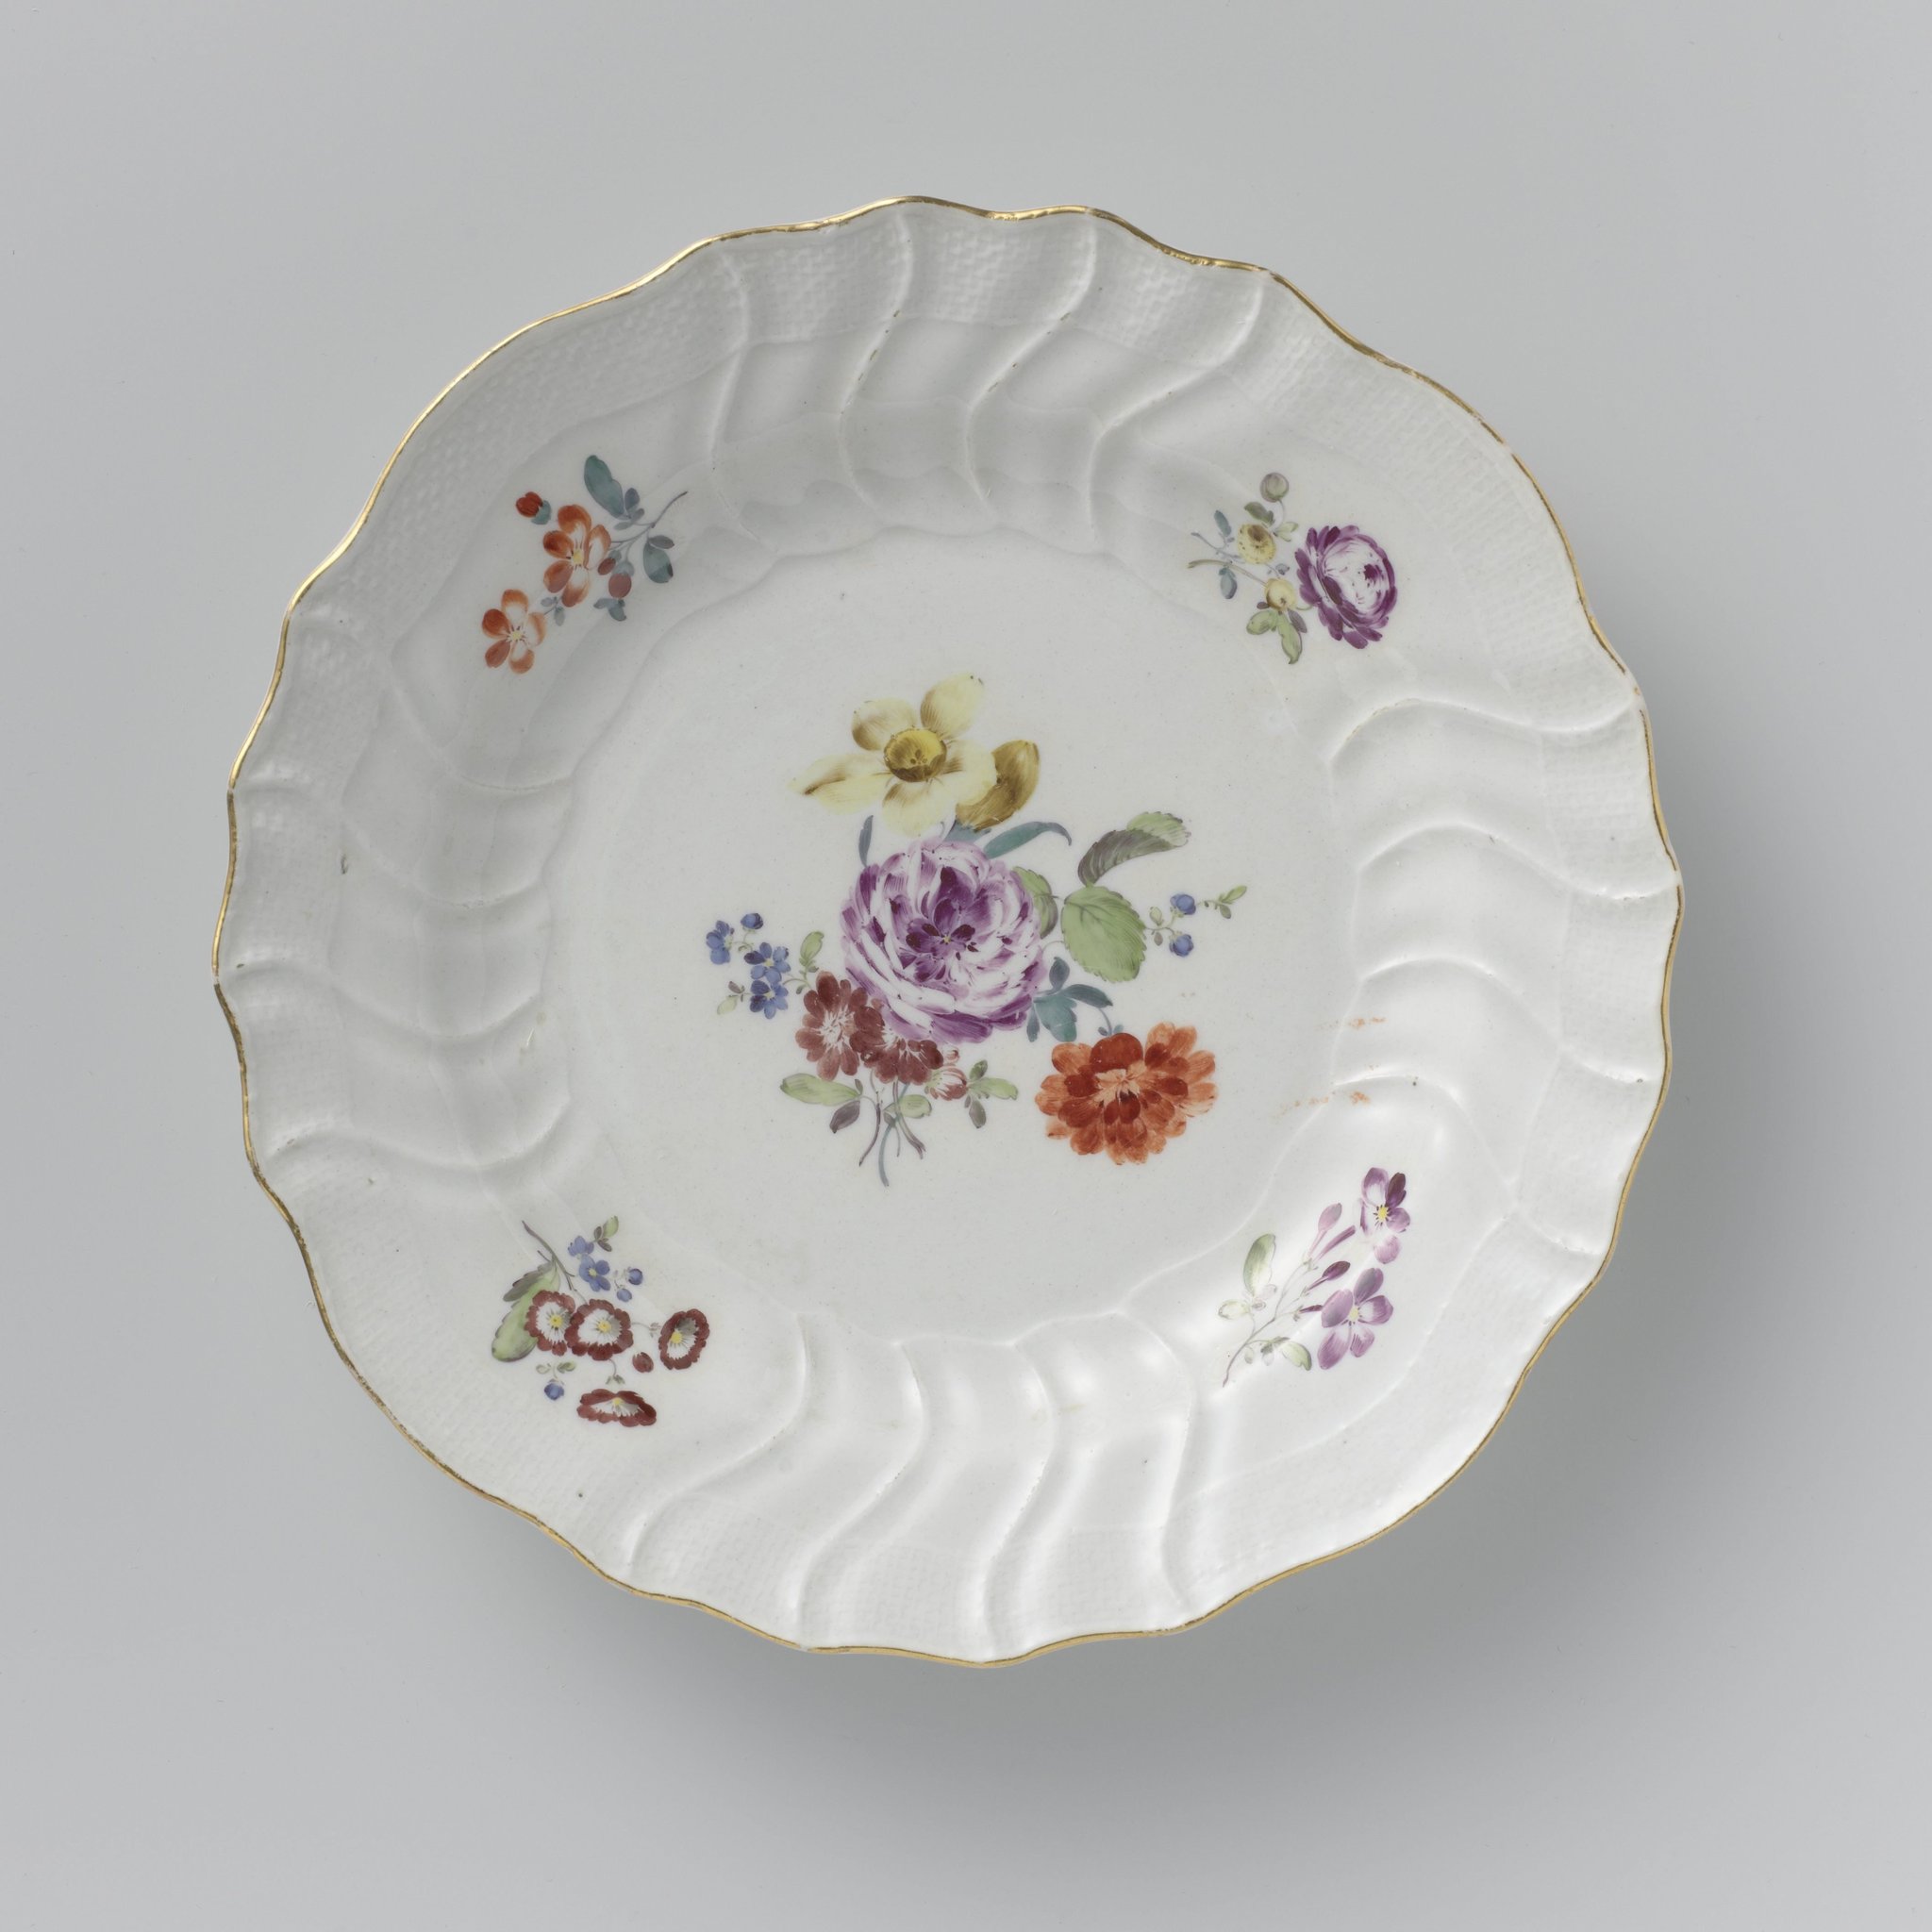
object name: plate dish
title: Bord, veelkleurig beschilderd met Deutsche Blumen, insekten en vruchten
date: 1750-1760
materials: porcelain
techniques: painted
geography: meissen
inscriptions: factory mark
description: Rond bord van beschilderd porselein. De rand is versierd met het Neuozier-patroon in reliëf. De beschildering bestaat uit Deutsche Blumen, insekten en vruchten. Het bord is gemerkt en hoort bij een servies (BK-17474-1 t/m BK-17474-253).